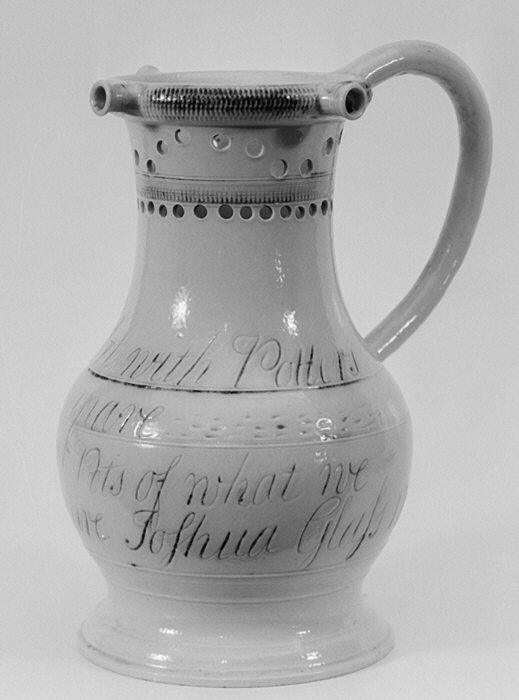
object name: puzzle jug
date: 1766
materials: stoneware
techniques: salt glaze